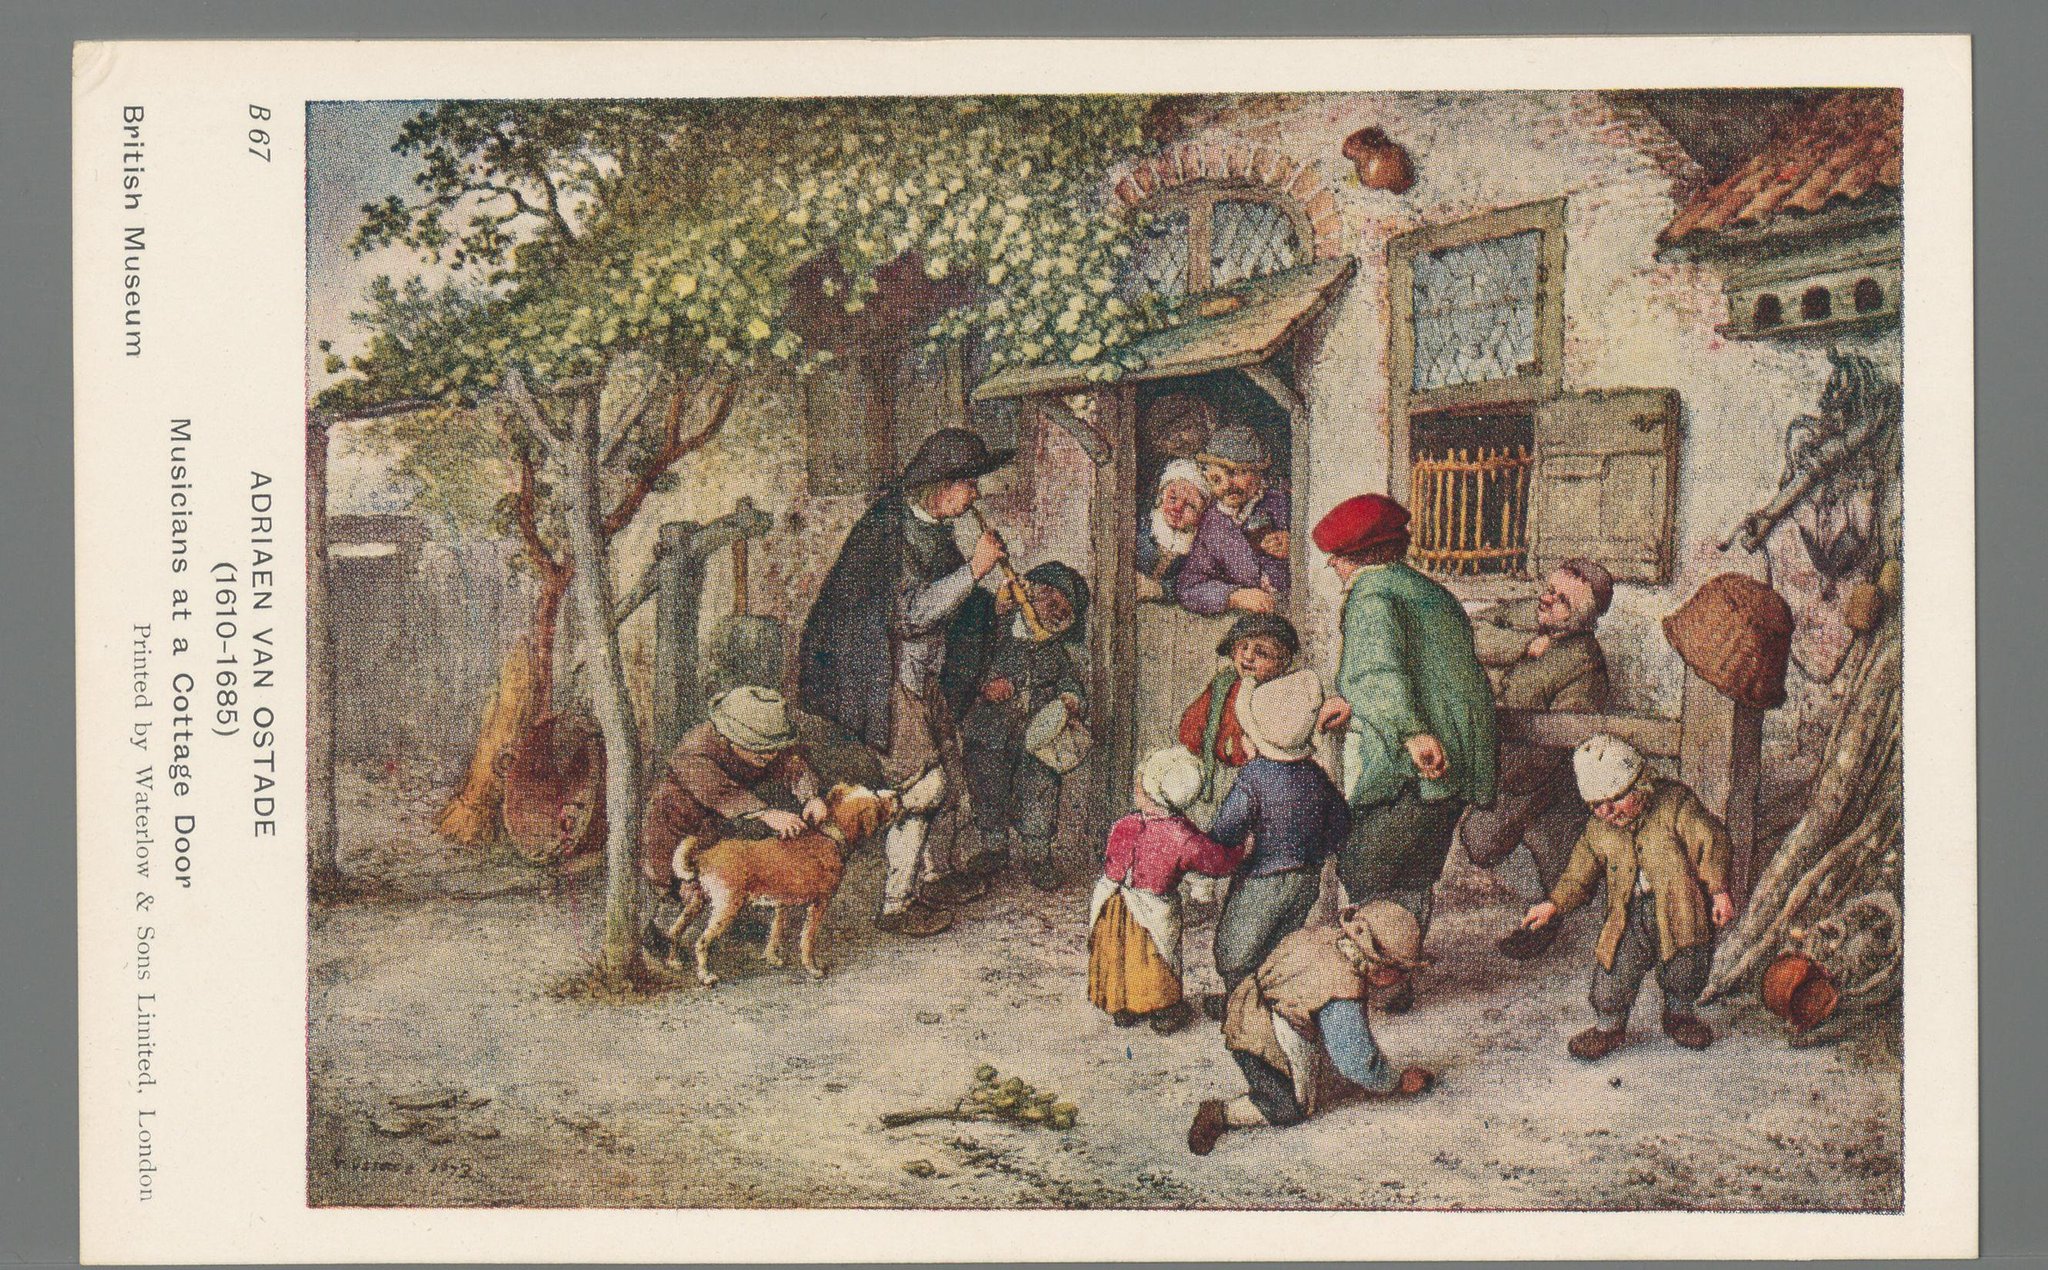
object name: photomechanical print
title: Adriaen van Ostade (1610-1685). Musicians at a cottage door. British Museum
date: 1902-1930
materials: cardboard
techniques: color autotype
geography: london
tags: permanent exhibition, museum, picture, painting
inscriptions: collector's mark: ‘AFE v S’